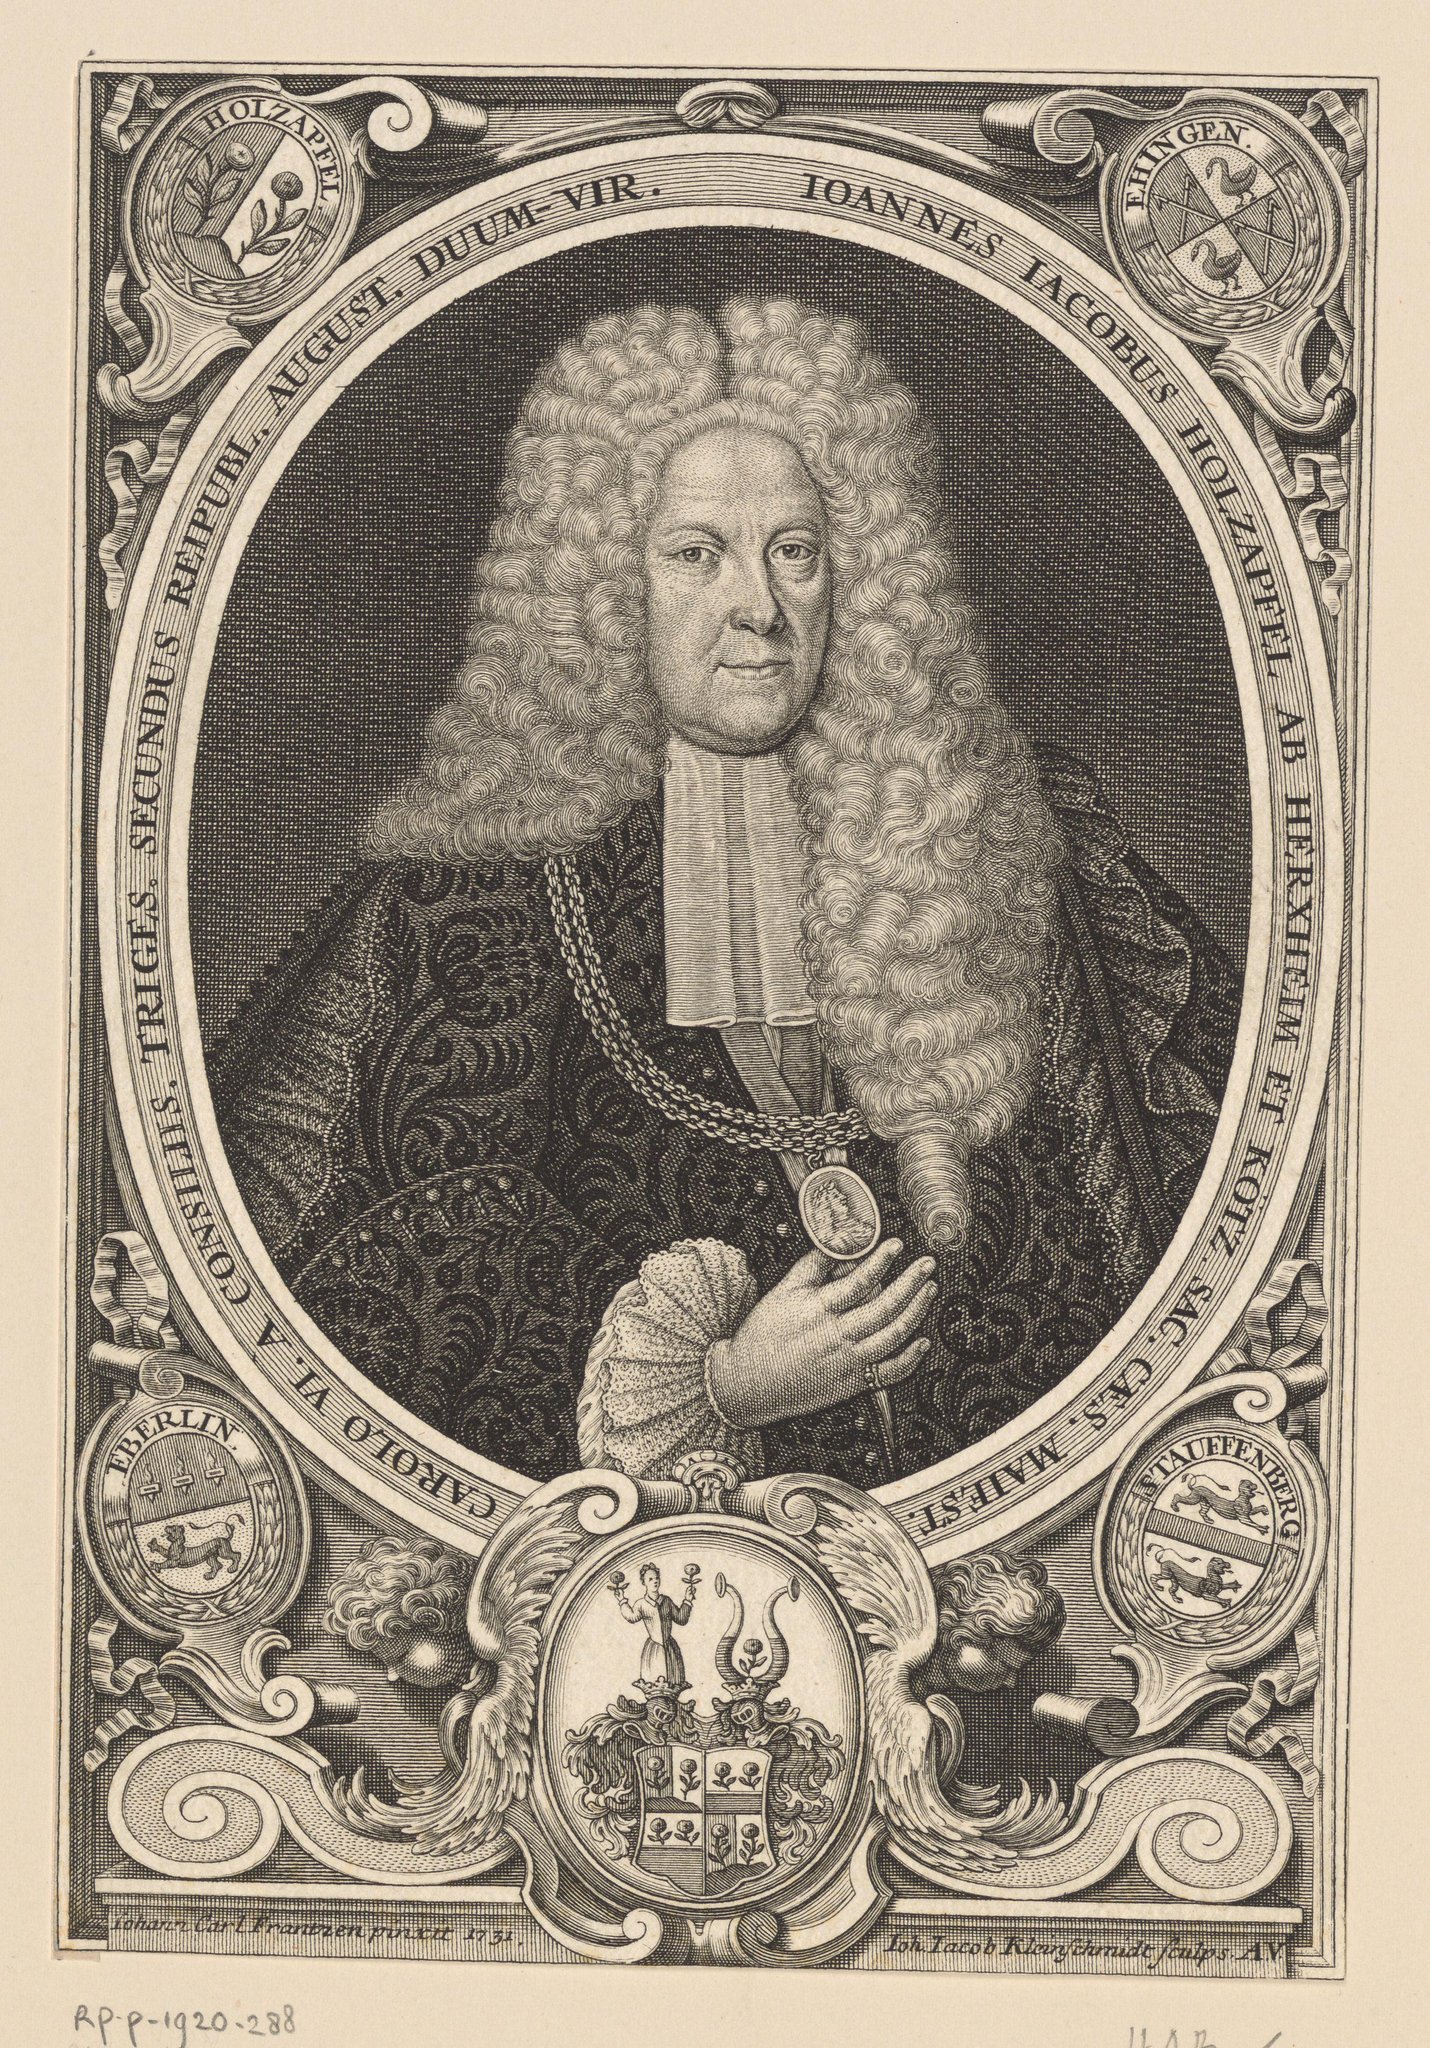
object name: print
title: Portret van Johann Jacob Holzapfel von Herxheim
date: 1731-1772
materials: paper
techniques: engraving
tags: adult man, historical persons, armorial bearing, heraldry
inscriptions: collector's mark: Lugt 2228